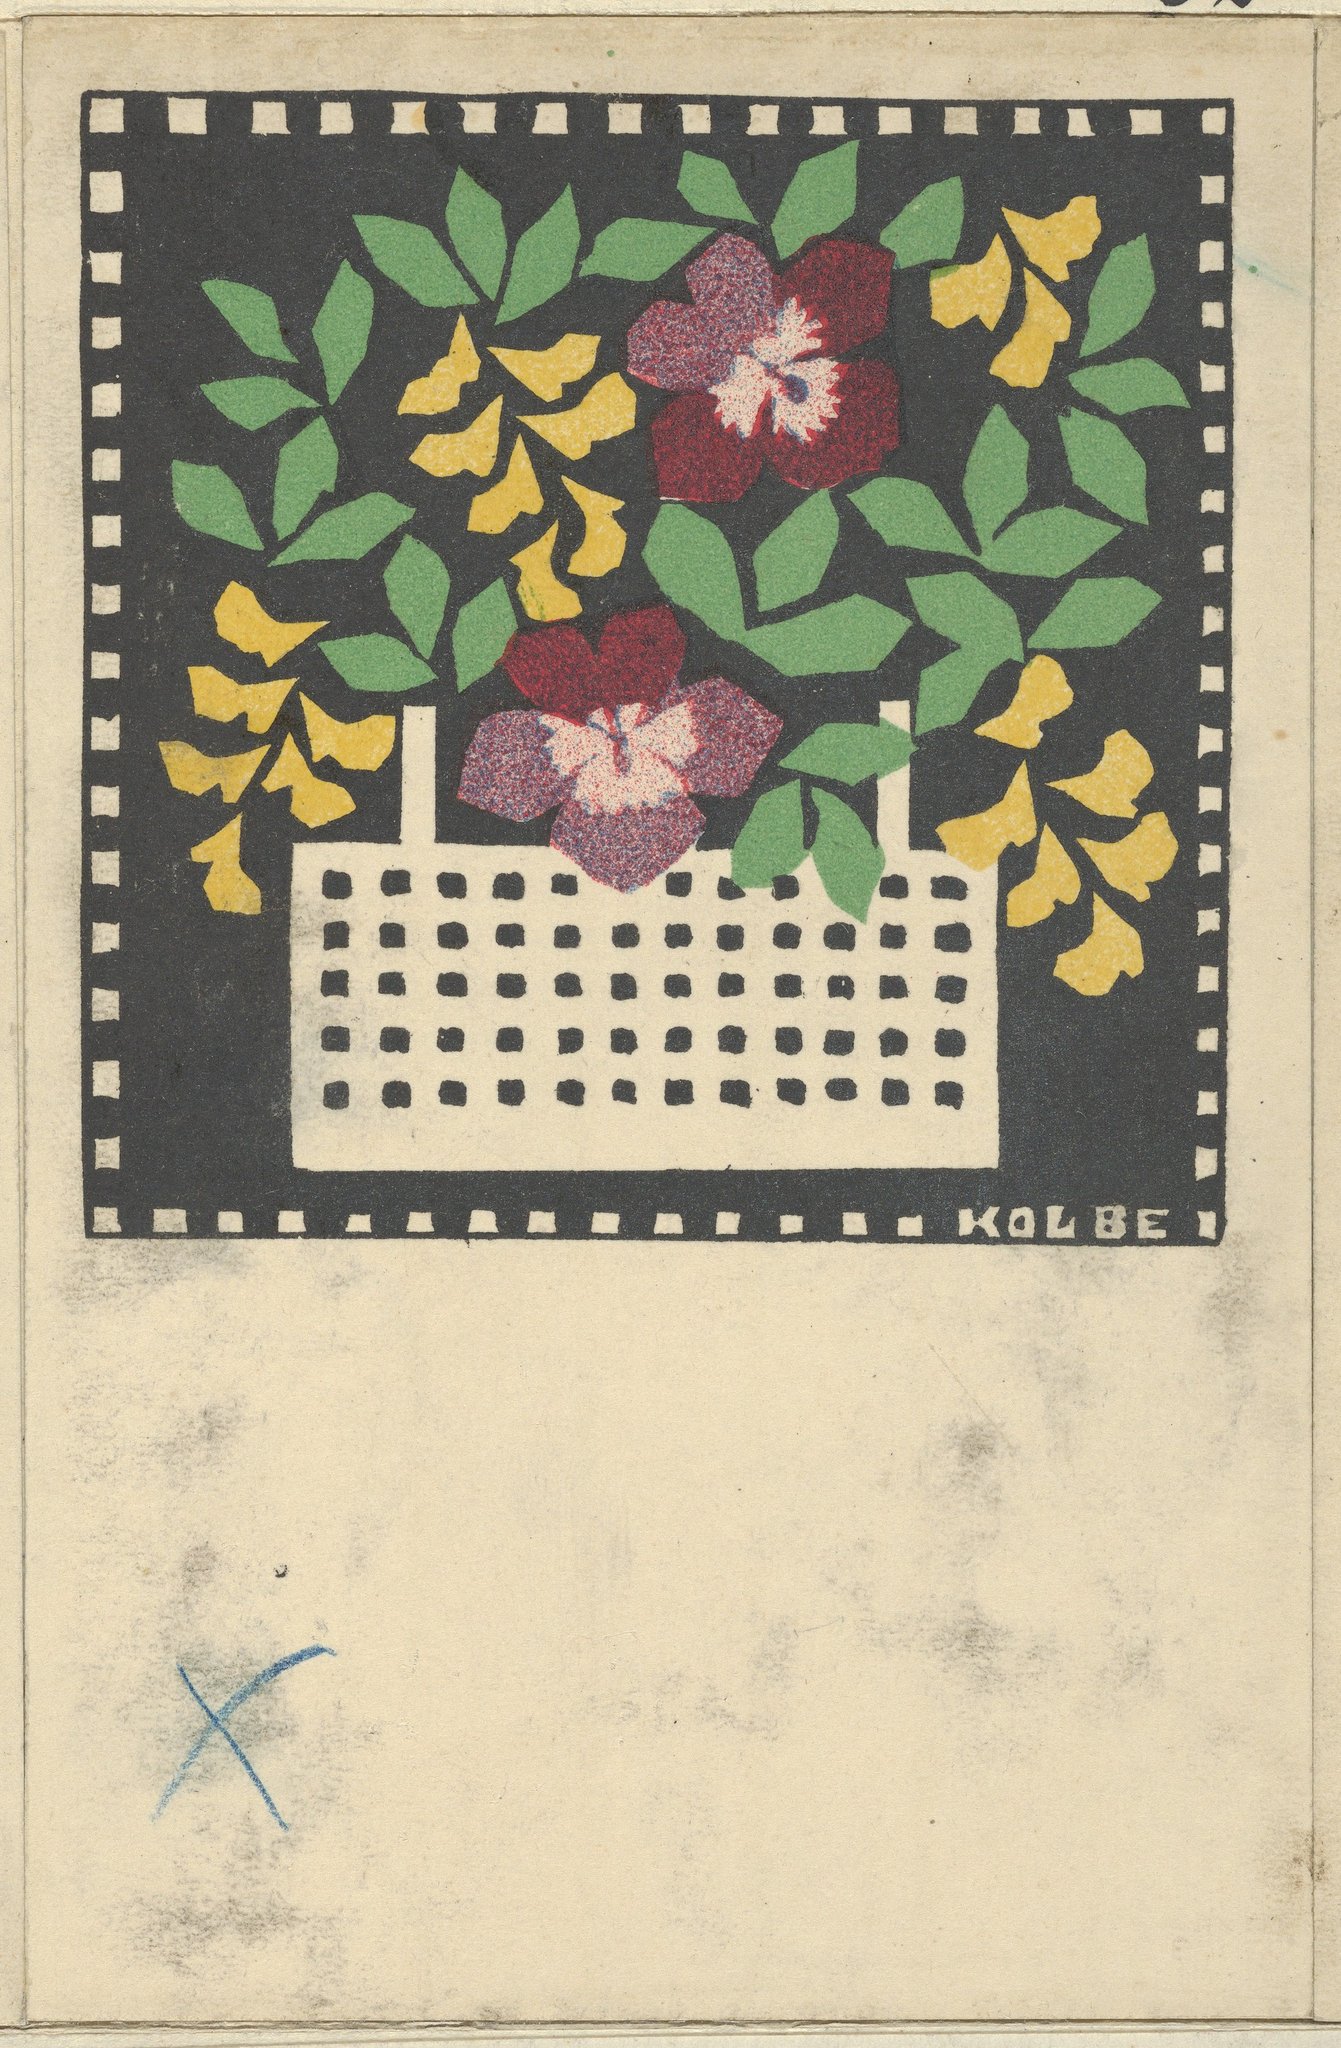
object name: print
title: Basket of Flowers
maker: leopoldine kolbe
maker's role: artist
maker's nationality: austrian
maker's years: 1870-1912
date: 1907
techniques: lithograph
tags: flowers,leaves